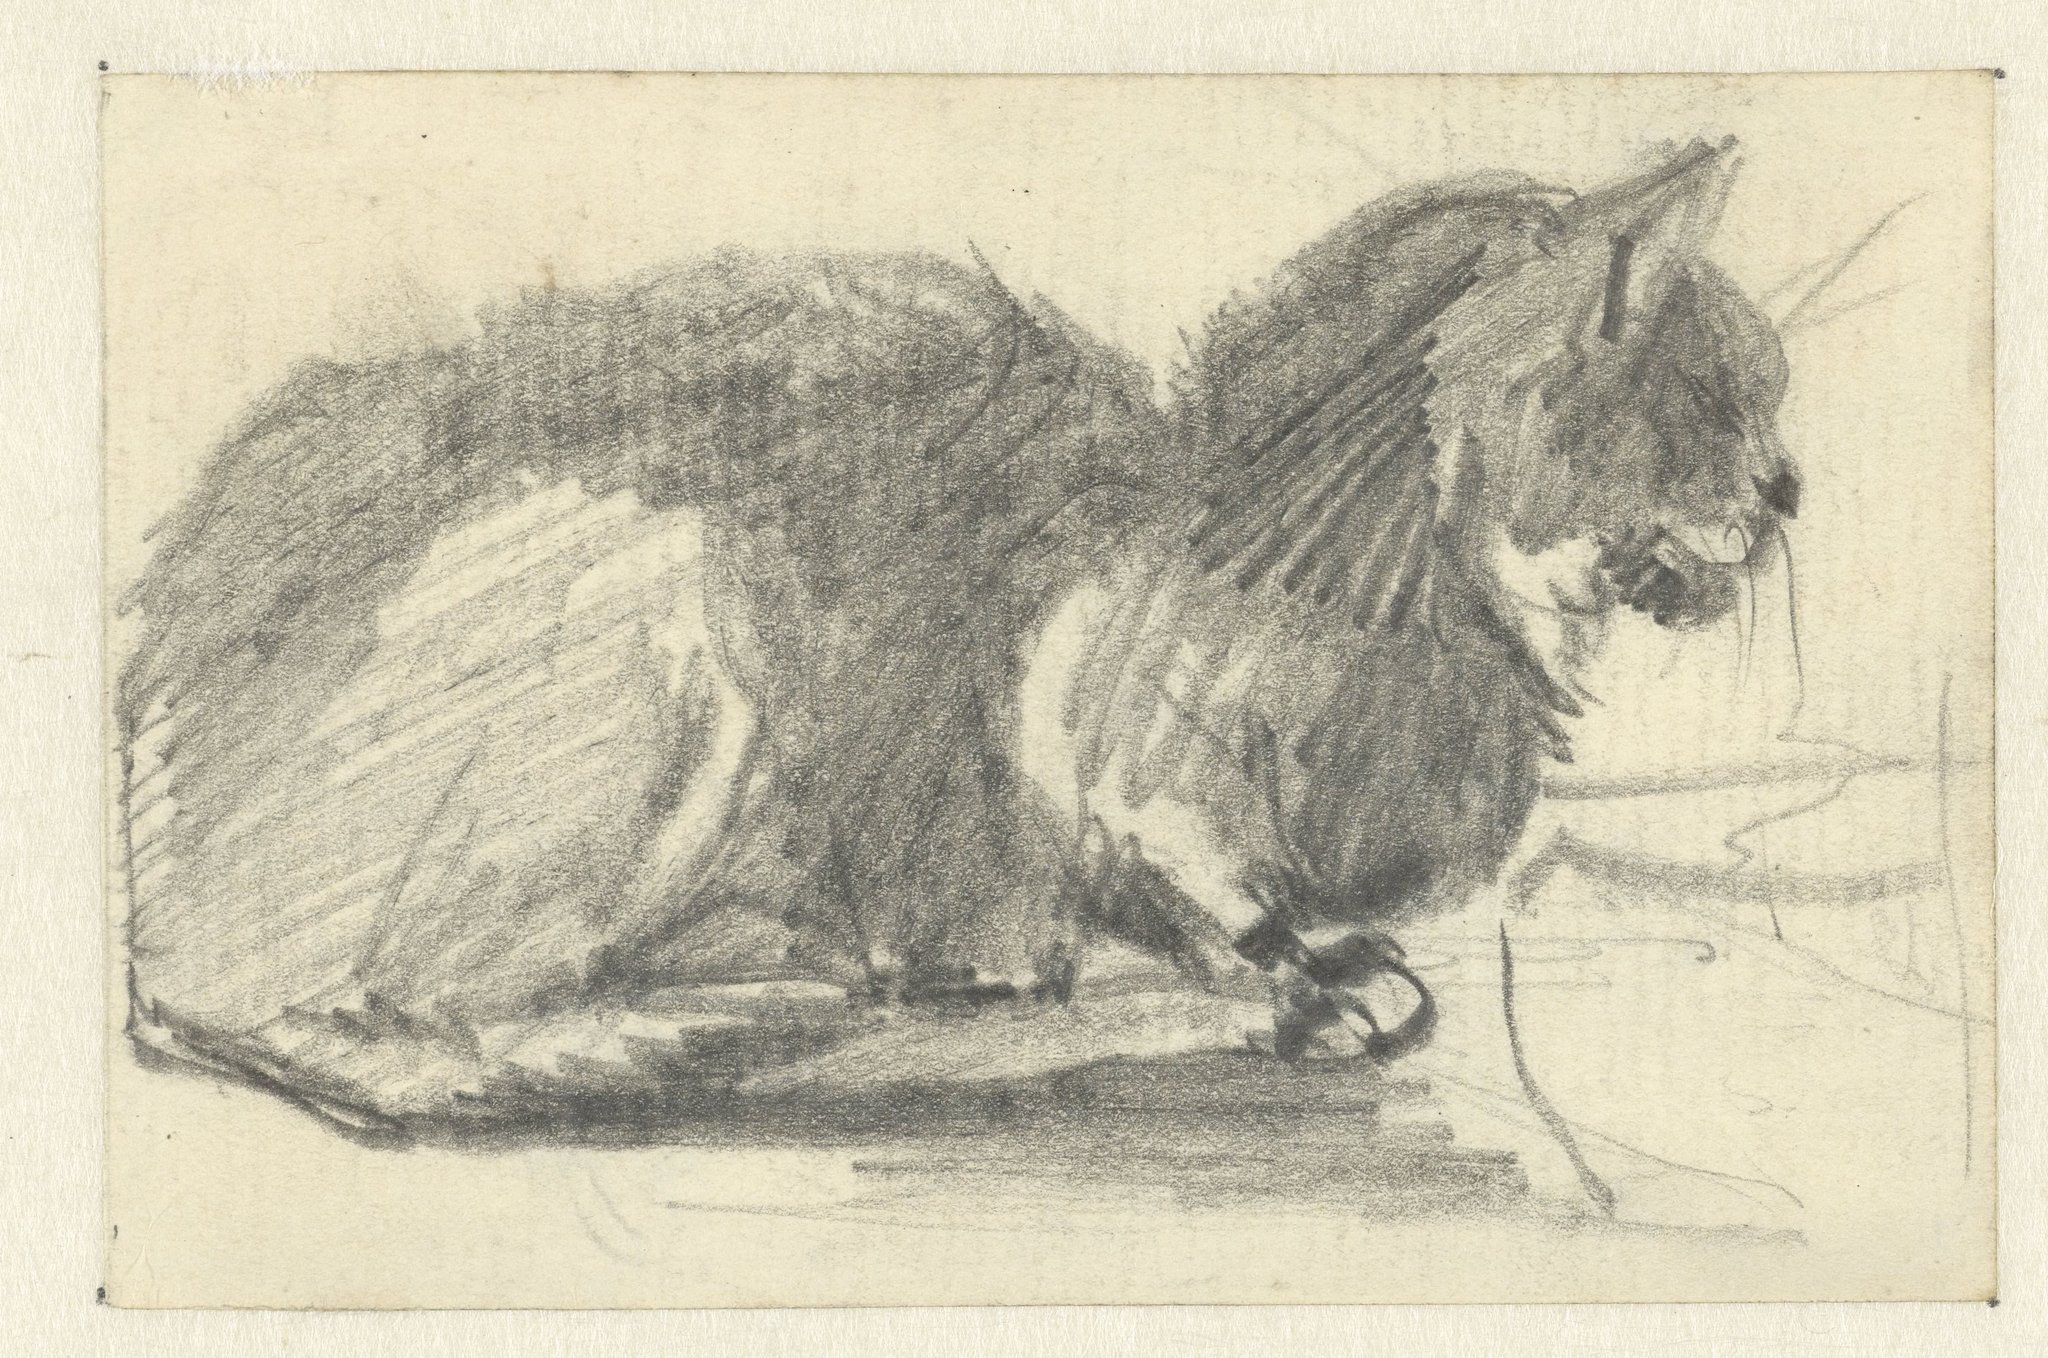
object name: drawing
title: Liggende kat, naar rechts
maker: guillaume anne van der brugghen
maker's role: draughtsman, print maker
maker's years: 1812-1891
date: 1821-1891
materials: paper, pencil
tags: cat